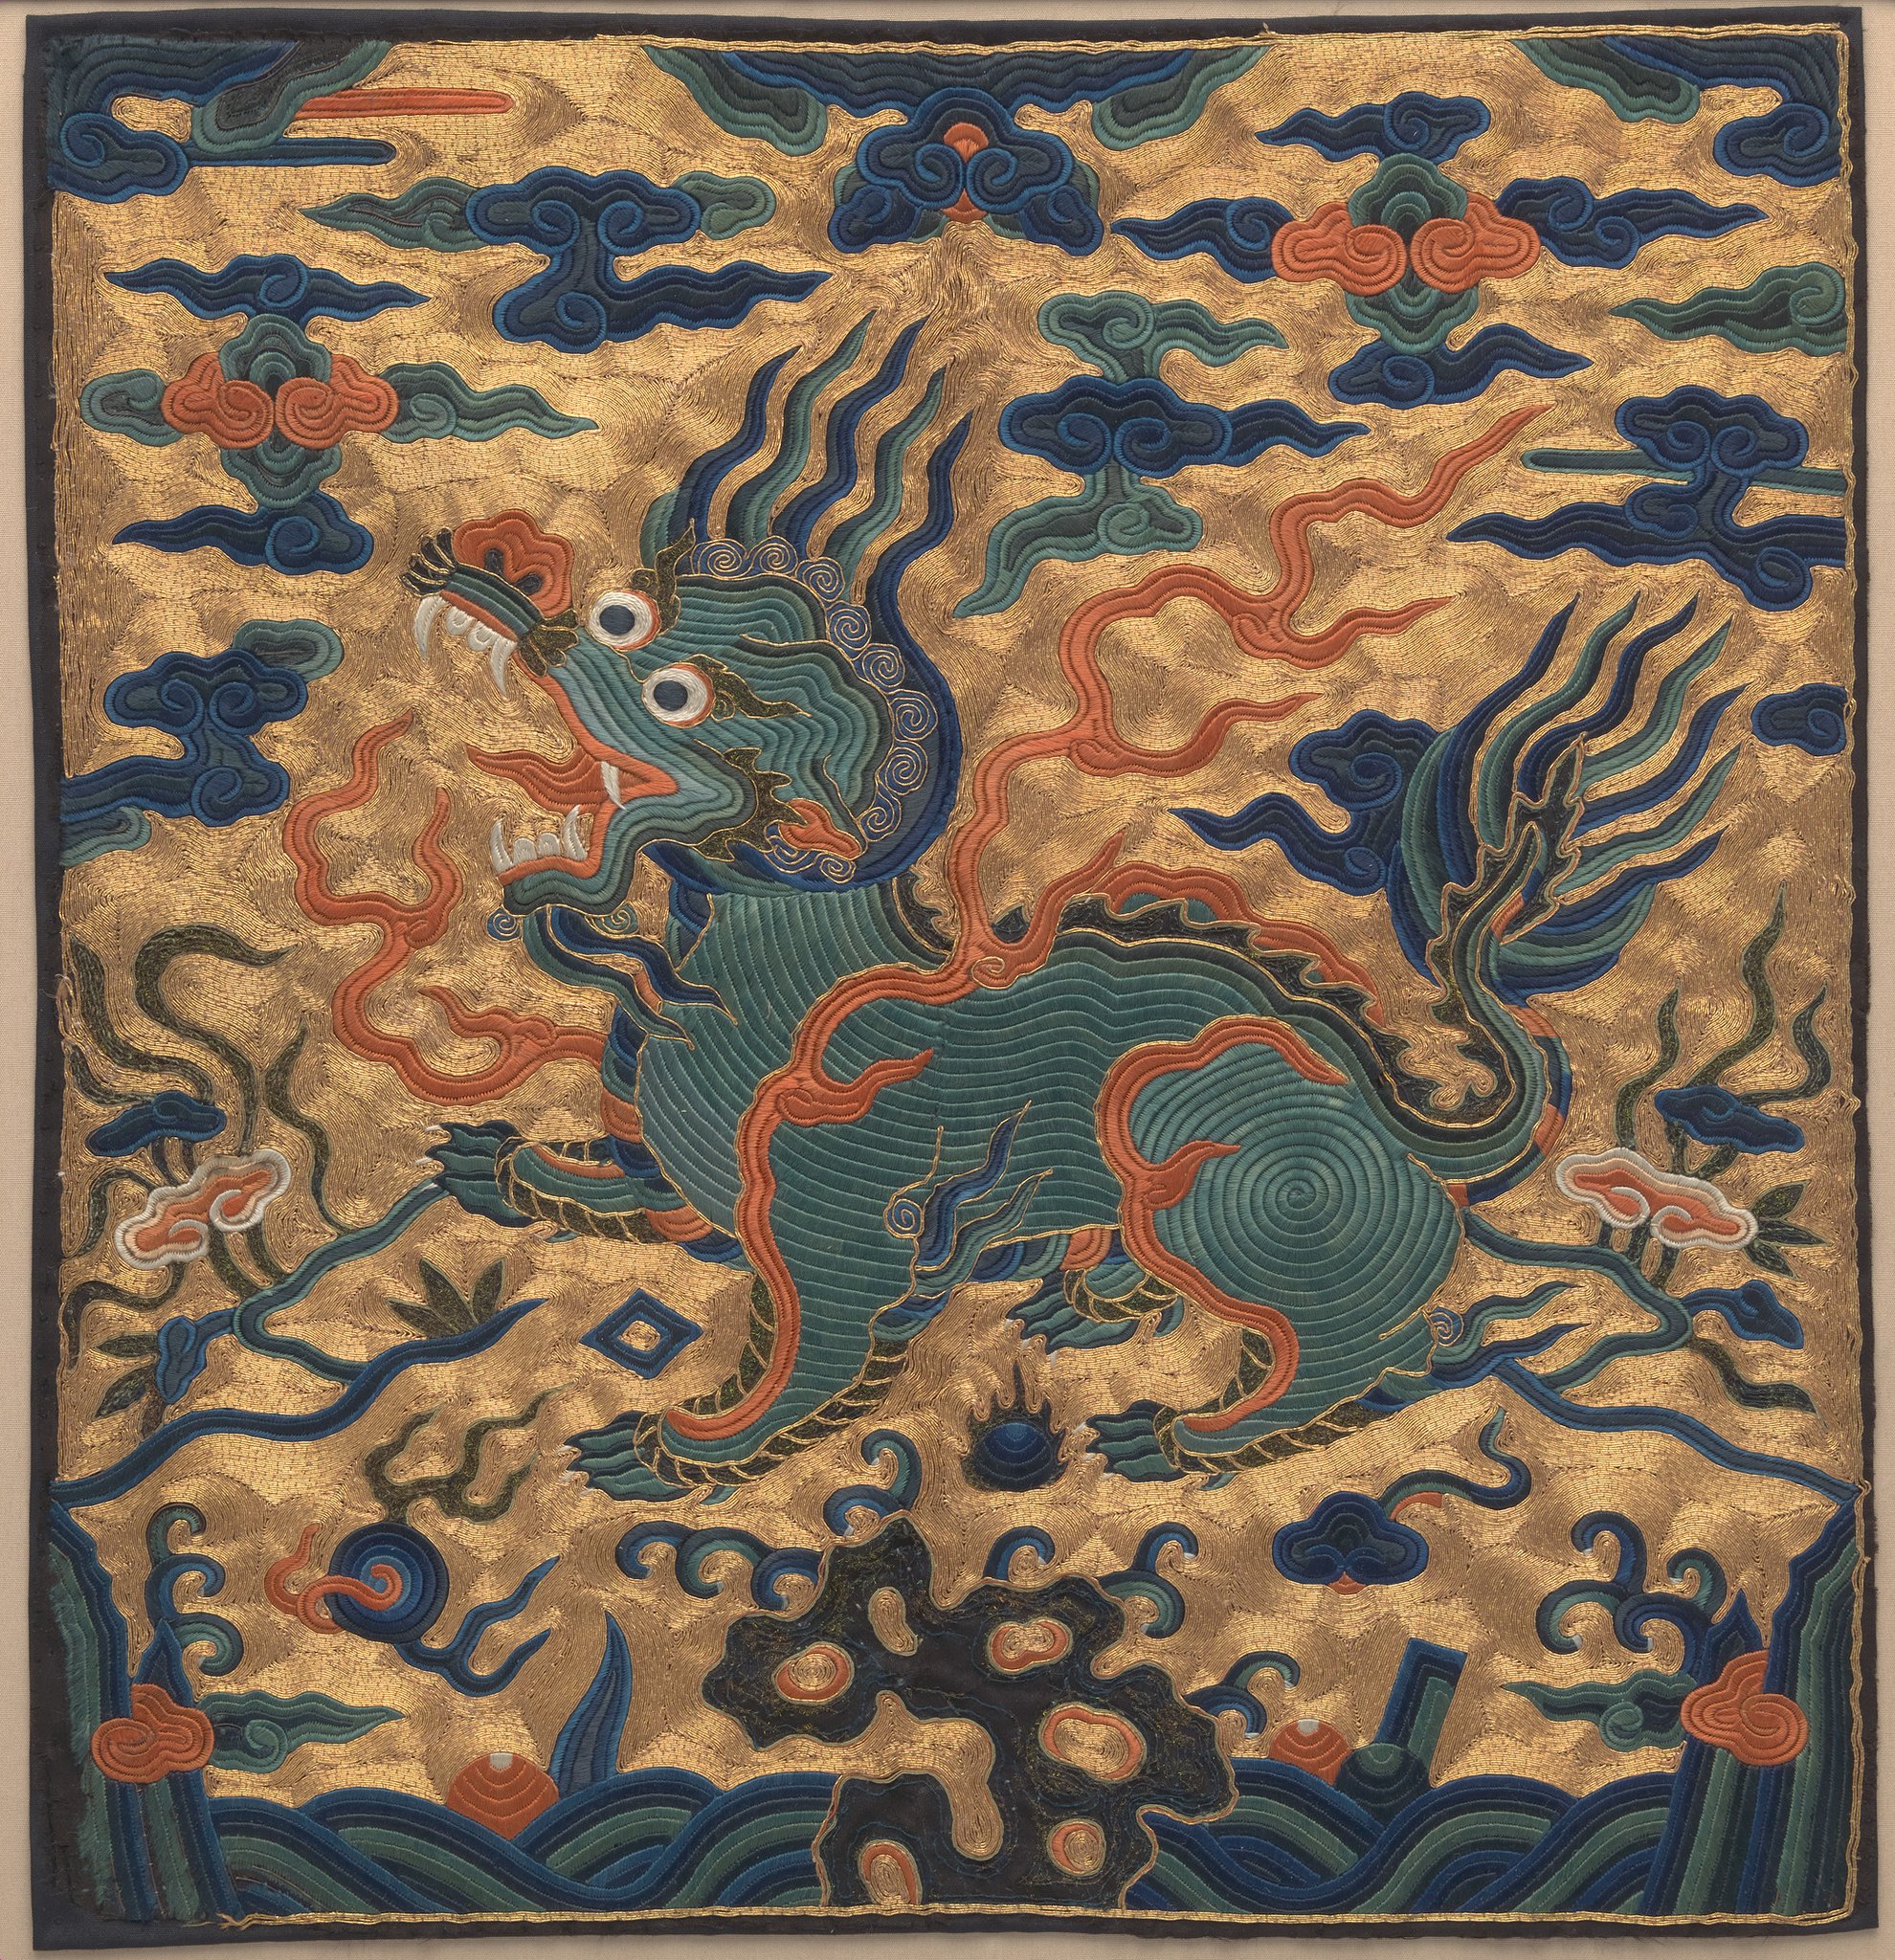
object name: rank badge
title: Rank Badge with Stylized Bear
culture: chinese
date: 1701-1800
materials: feather, metal thread, silk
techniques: embroidery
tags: bears